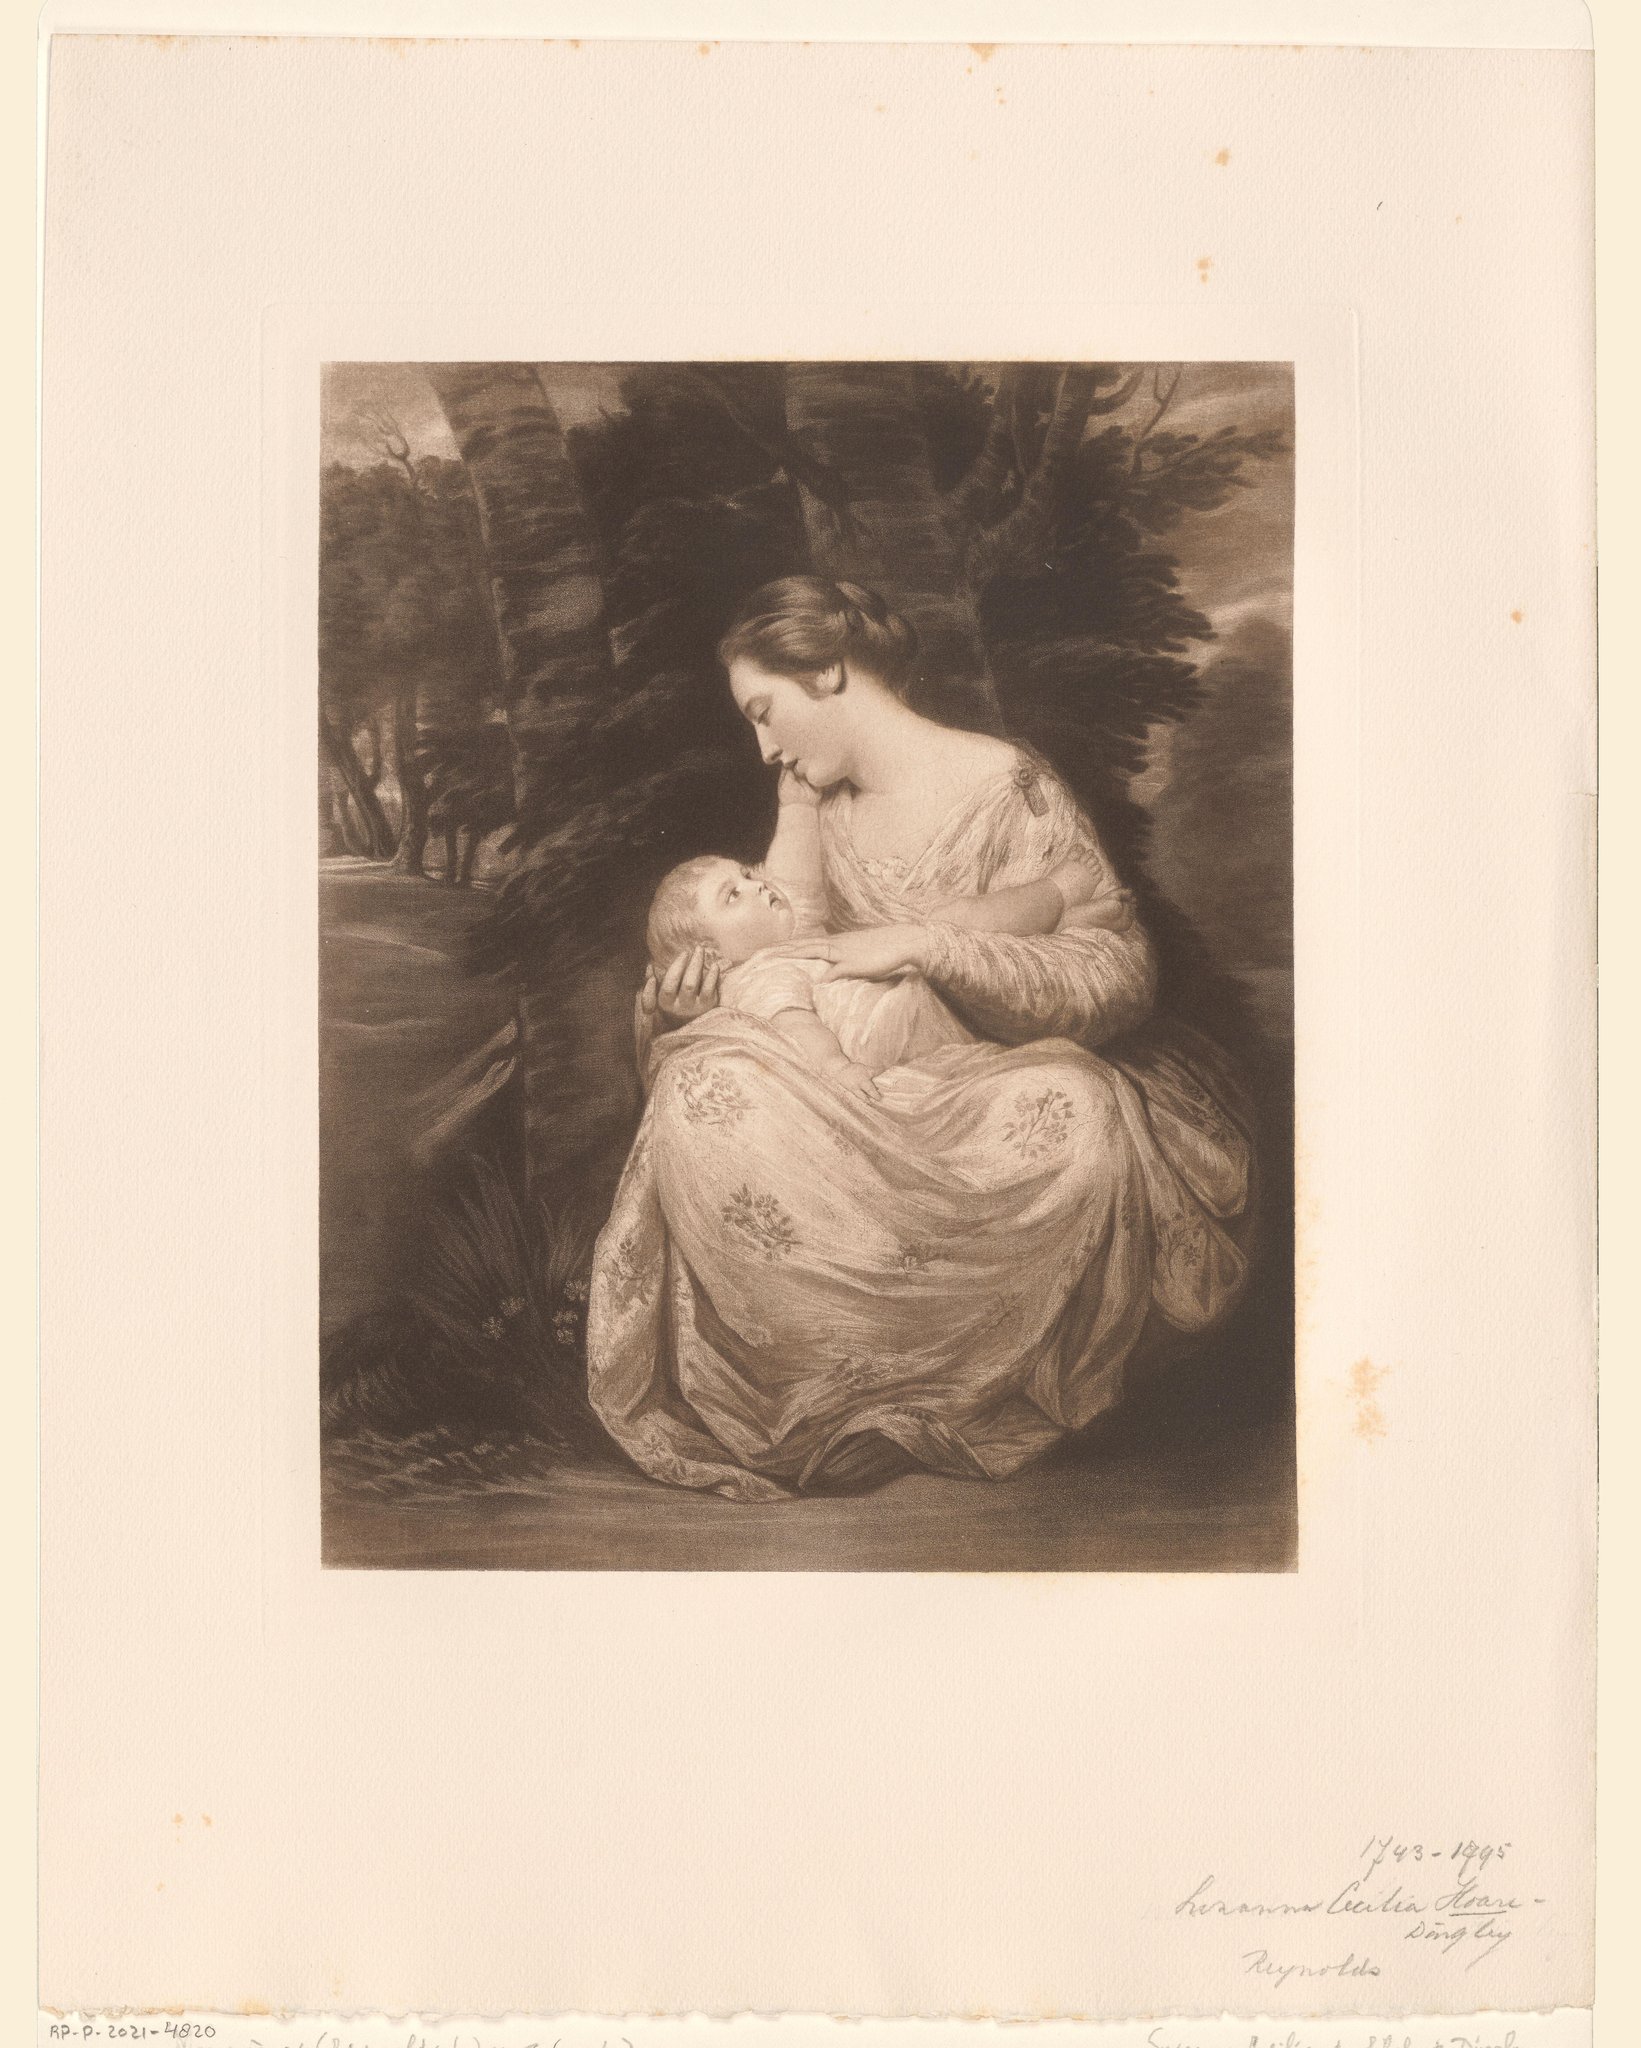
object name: photomechanical print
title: Portret van Susanna Cecilia Hoare met haar dochter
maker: Anonymous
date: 1870-1915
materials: paper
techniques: photoaquatint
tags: mother with daughter(s) (mother-love), historical persons - bb - woman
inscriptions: collector's mark: Lugt 2228